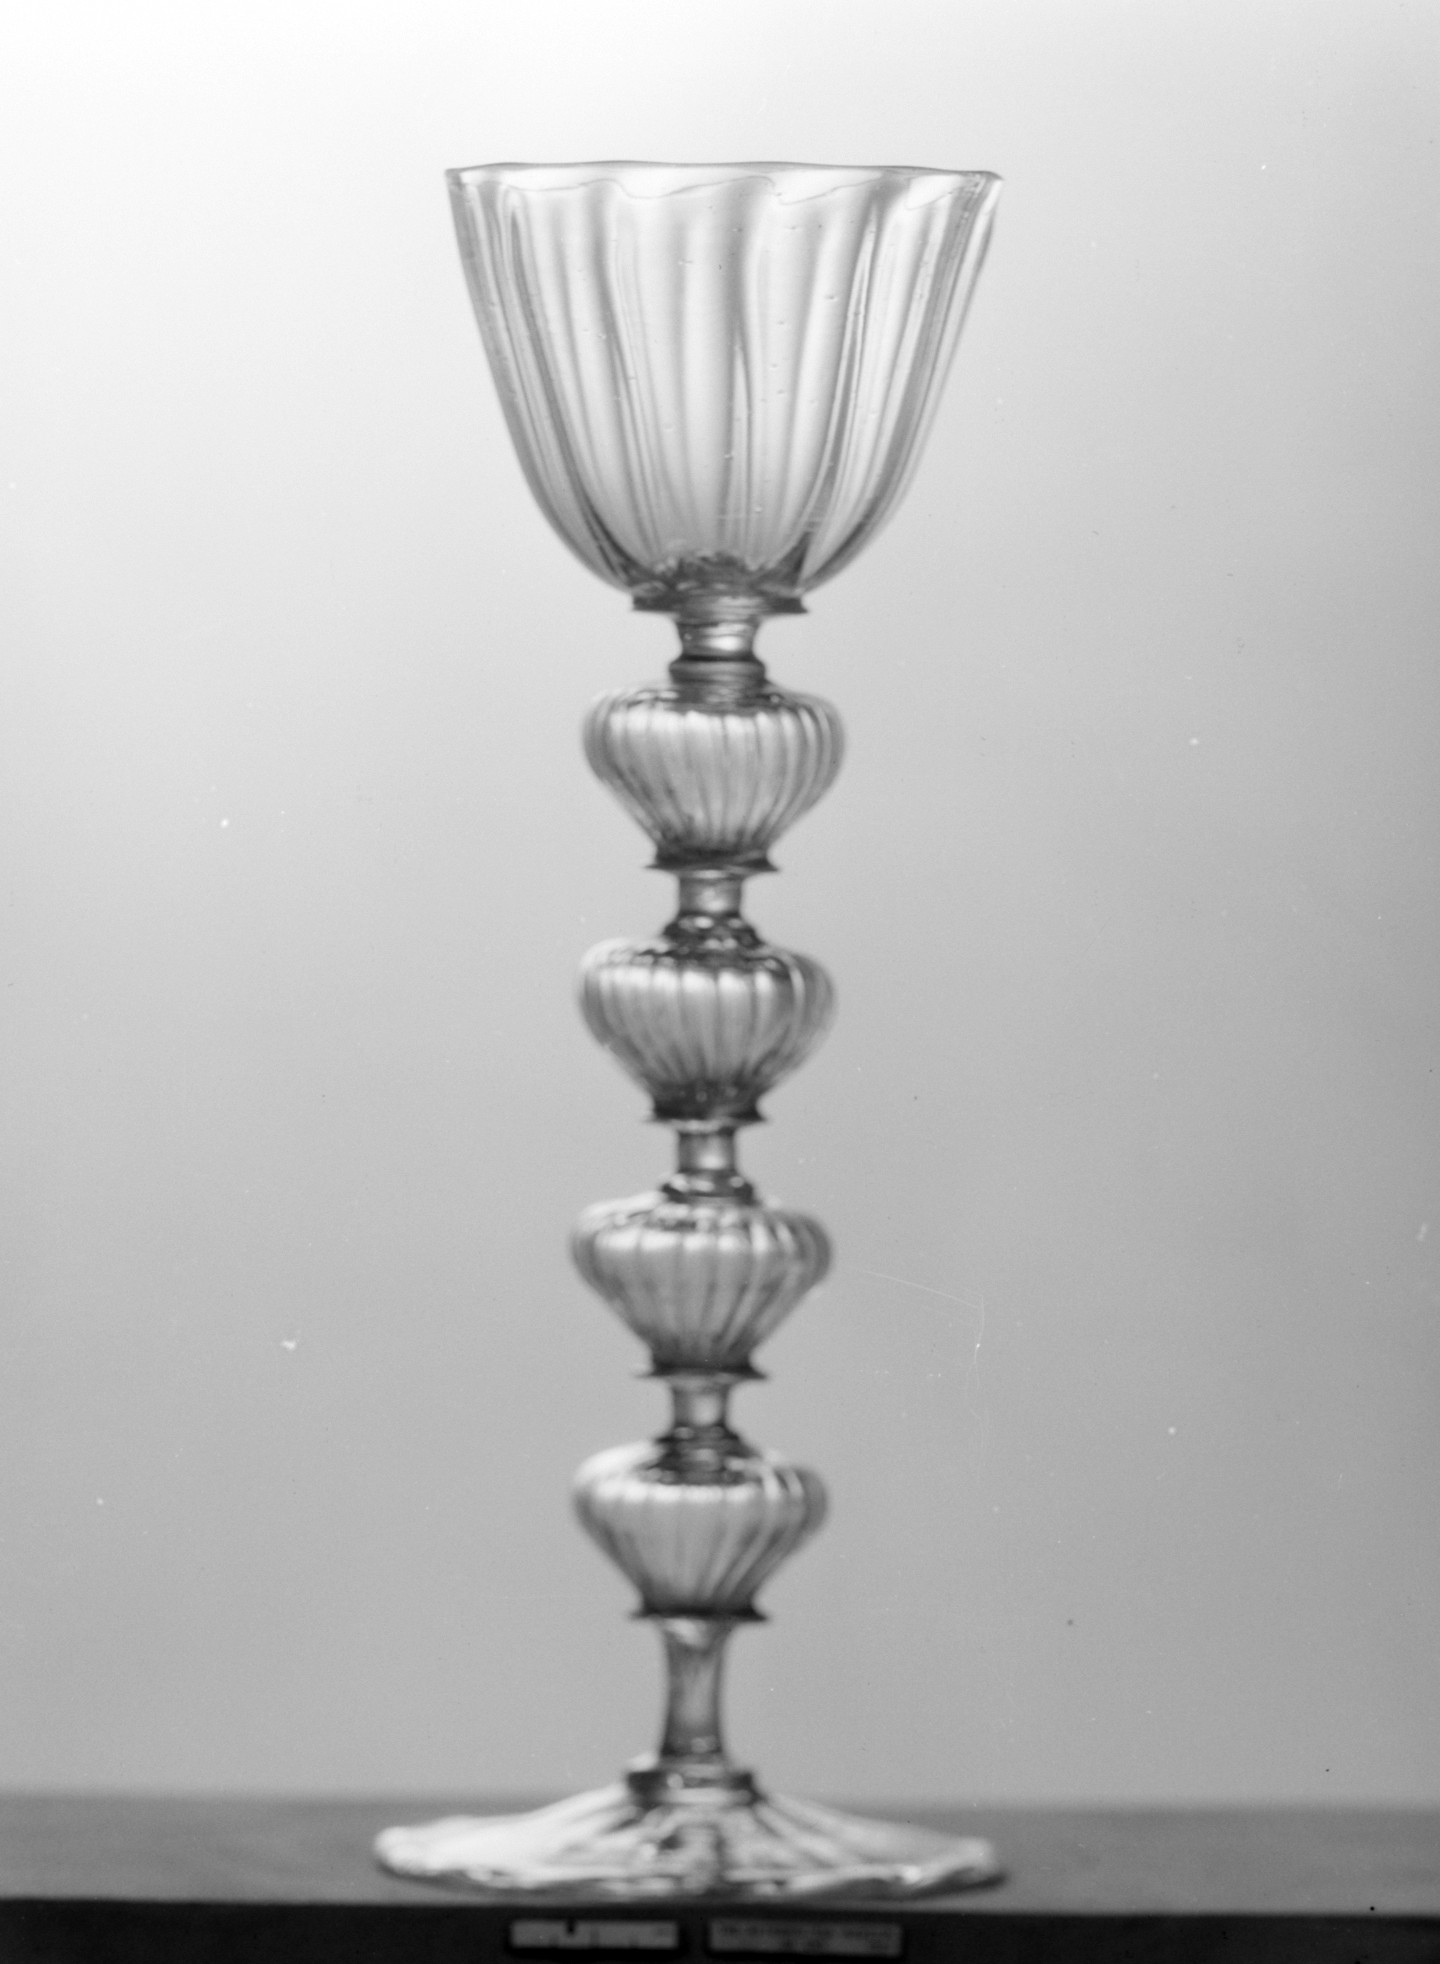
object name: wineglass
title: Wineglass (Hohlpuffenglas)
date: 1601-1650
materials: glass